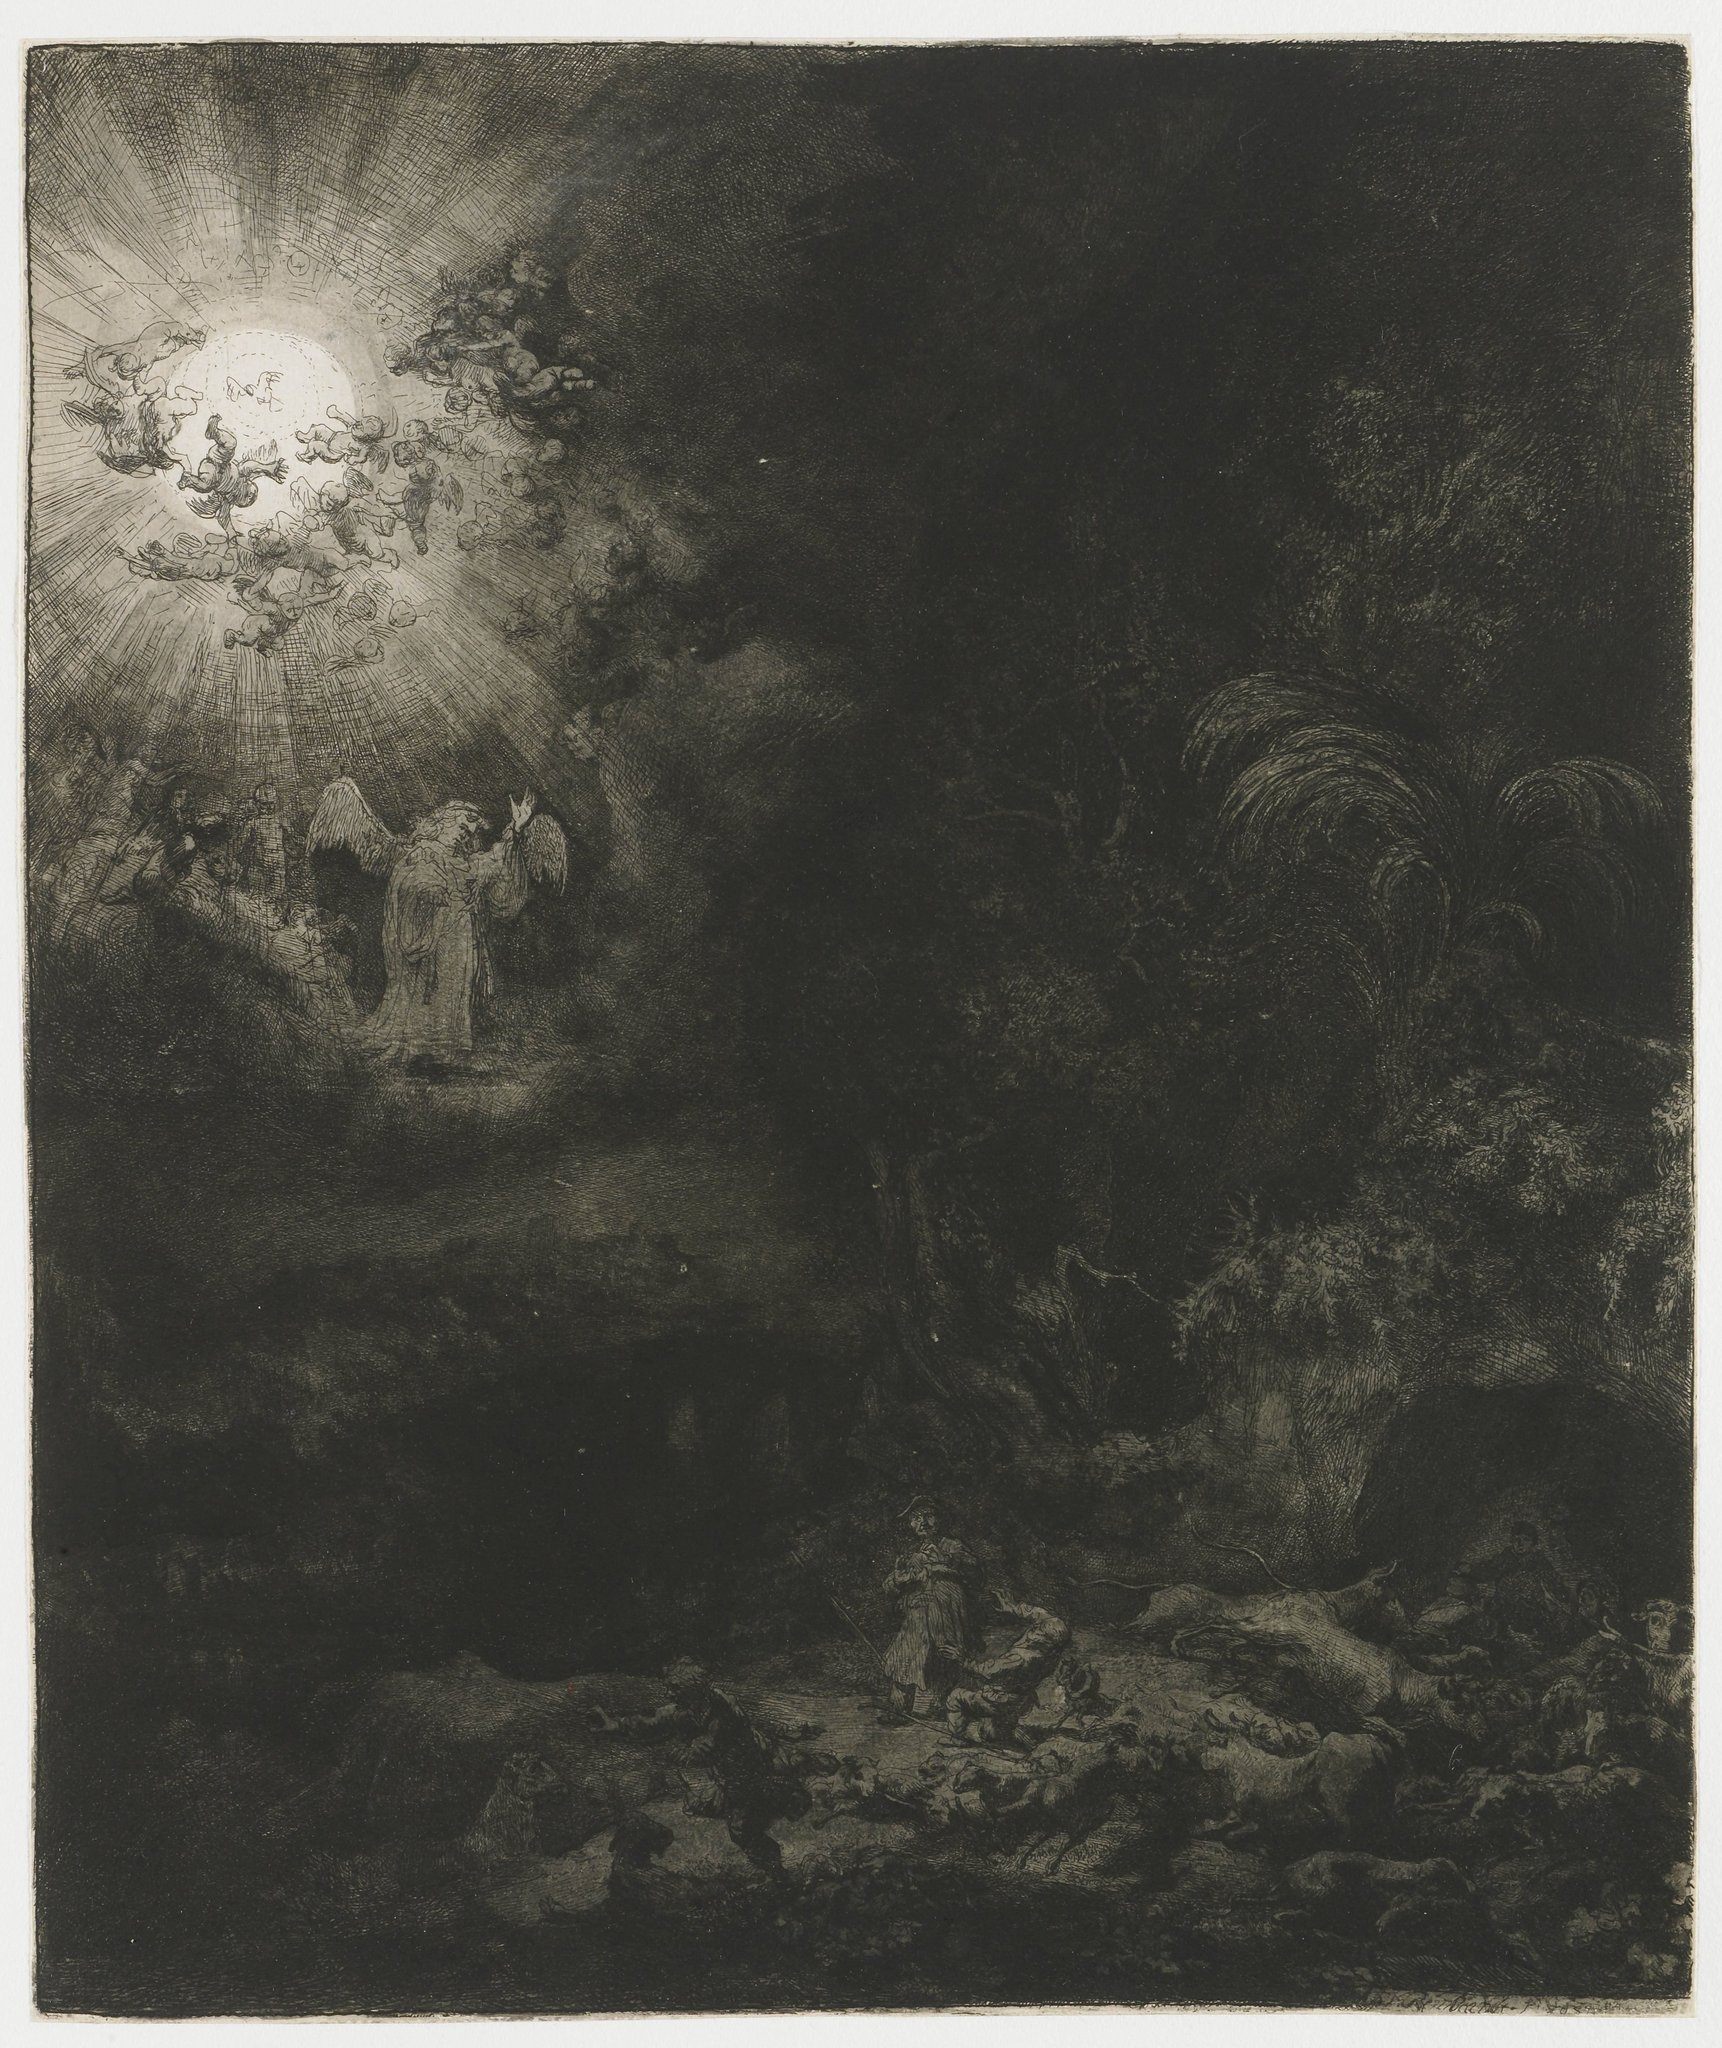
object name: print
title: The angel appearing to the shepherds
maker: rembrandt van rijn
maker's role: draughtsman, painter, print maker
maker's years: 1606-1669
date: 1634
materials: paper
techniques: drypoint, etching, intaglio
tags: annunciation of christ's birth to the shepherds (and/or shepherdesses) at night; a host of singing angels in the air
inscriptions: collector's mark: Lugt 240, signature and date: ‘Rembrandt. f. 1634’